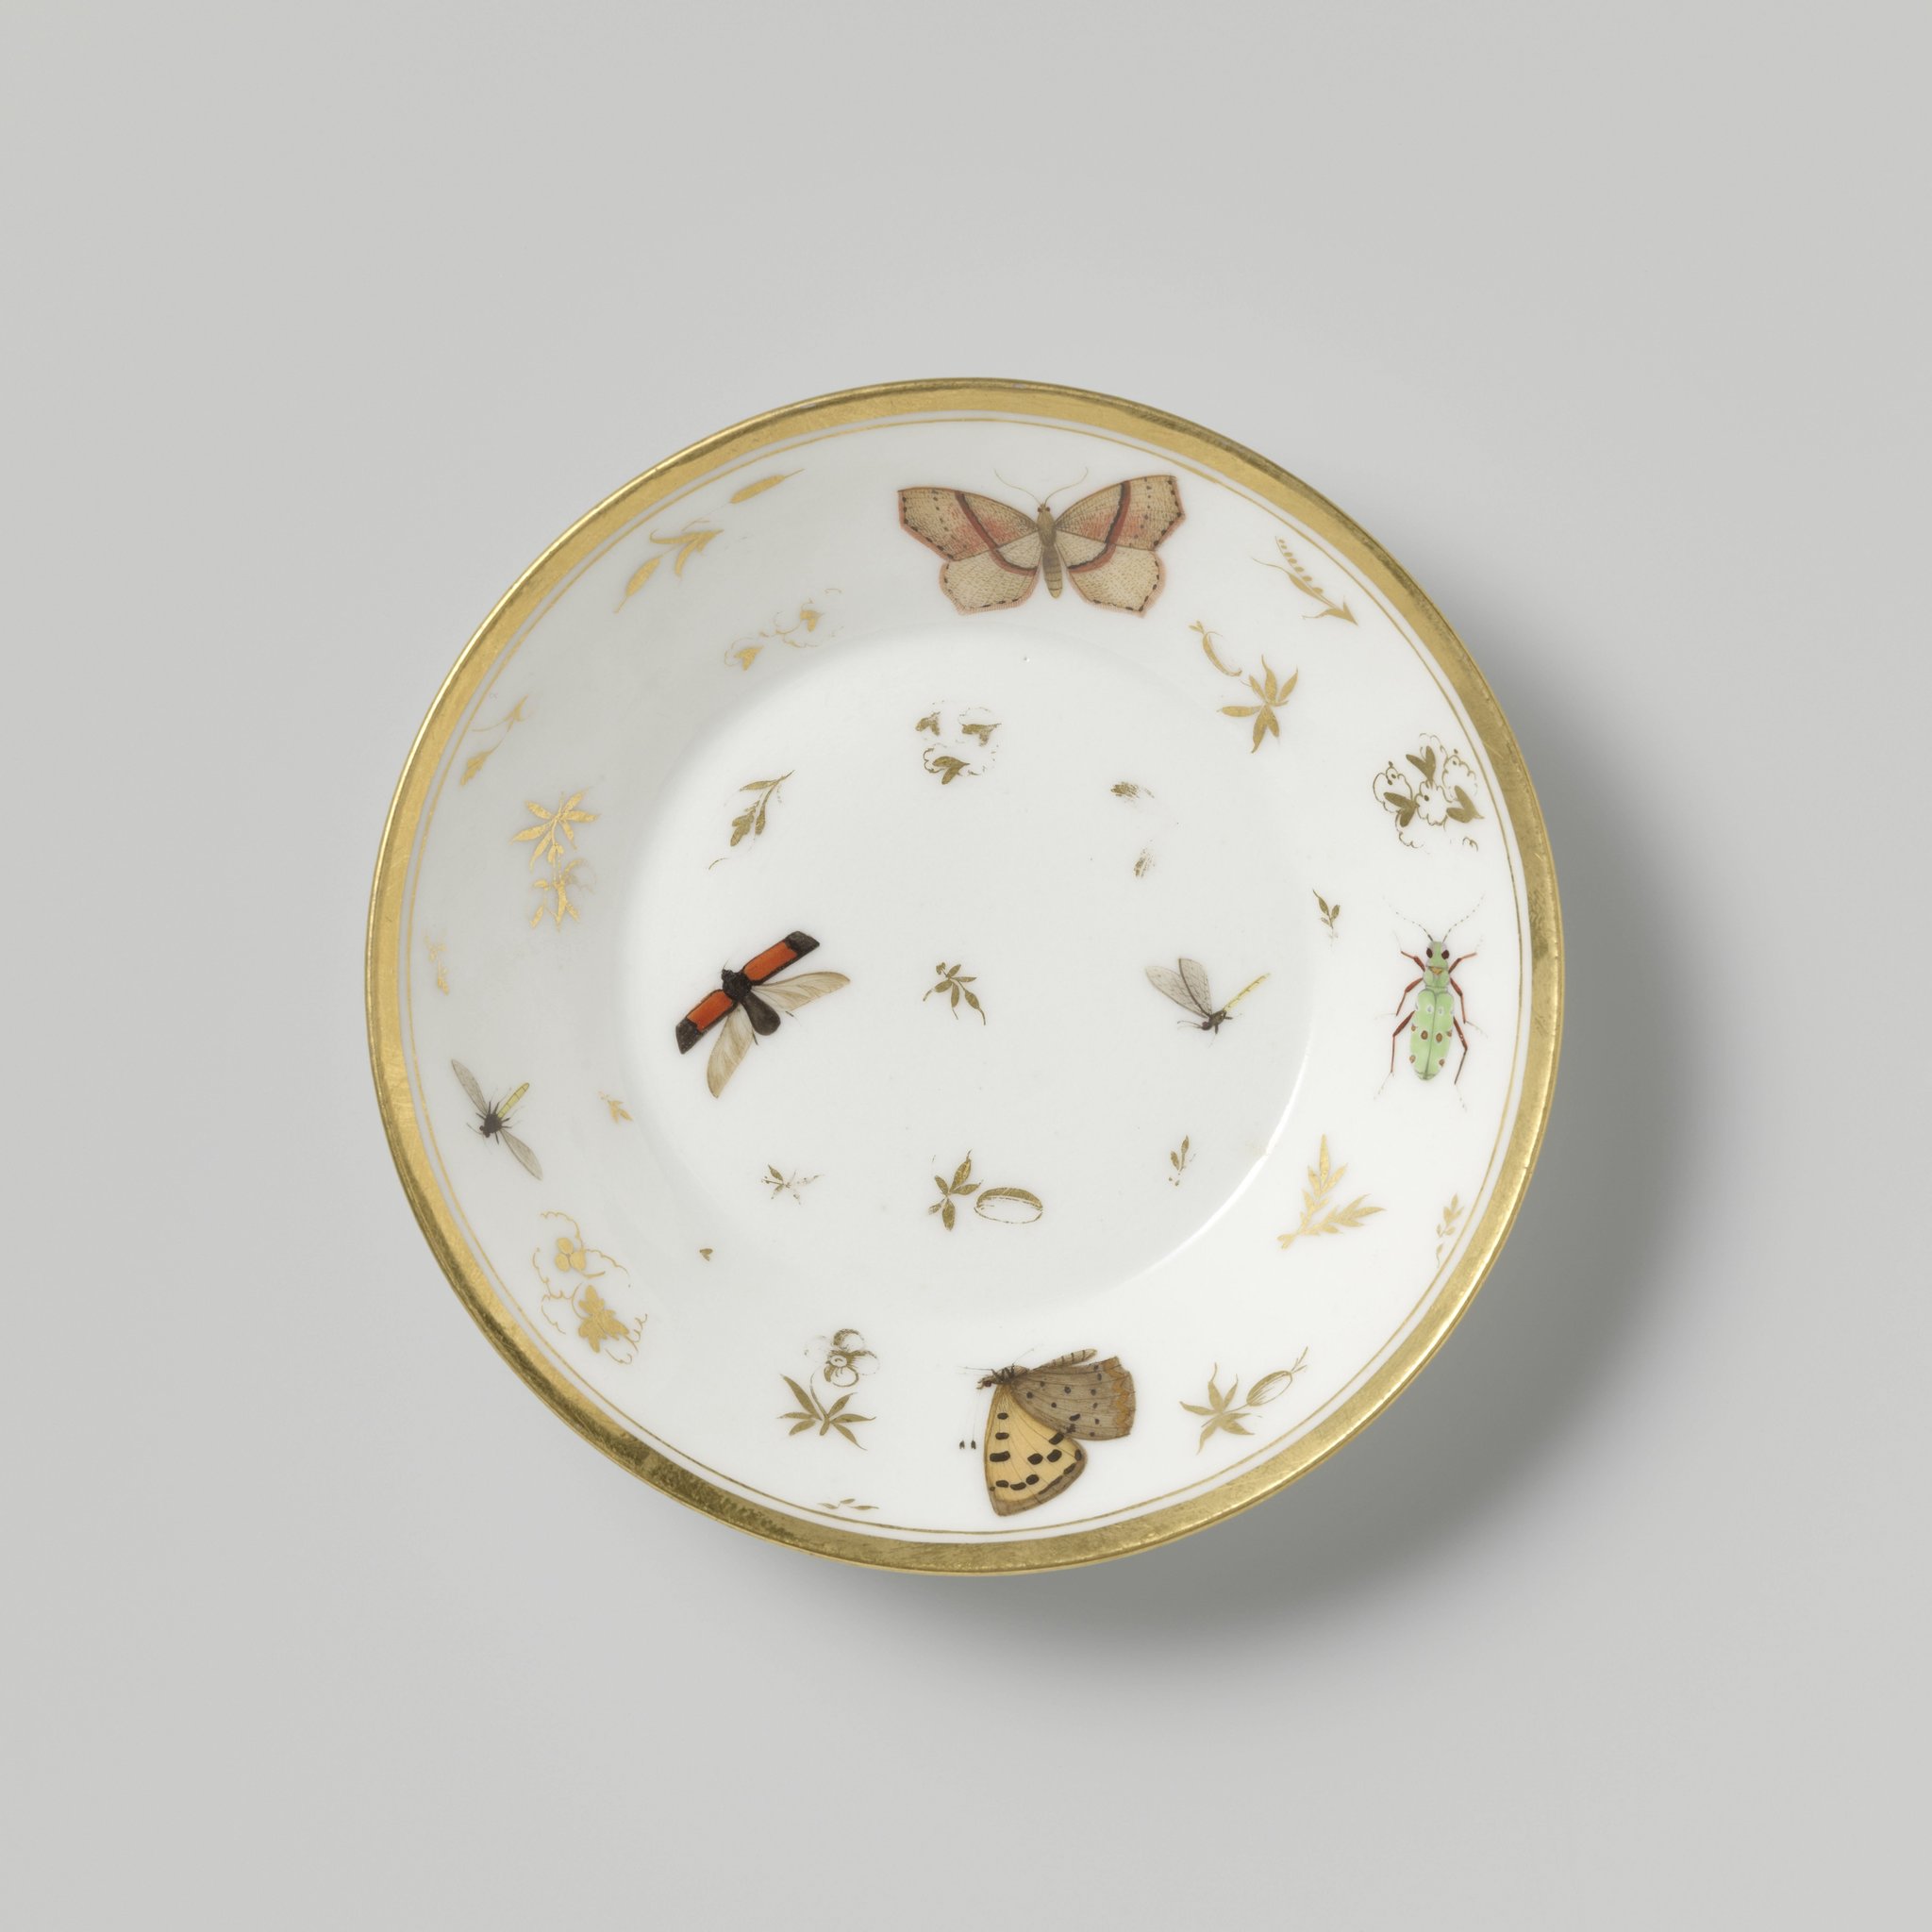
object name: service set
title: Saucer with insects, flower sprays and grapevines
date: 1797-1798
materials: glaze, gold, paint, porcelain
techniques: firing, forming, gilding, turning, vitrification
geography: paris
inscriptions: mark: ‘B/ X’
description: Schotel van porselein met een rechte wand, beschilderd op het glazuur in emailkleuren en goud. De voorzijde is bedekt met gekleurde insecten (vlinders, kevers, libellen, etc.) en in goud bloemtakken en druivenranken. Gouden rand. Gemerkt op de onderzijde met B en X.